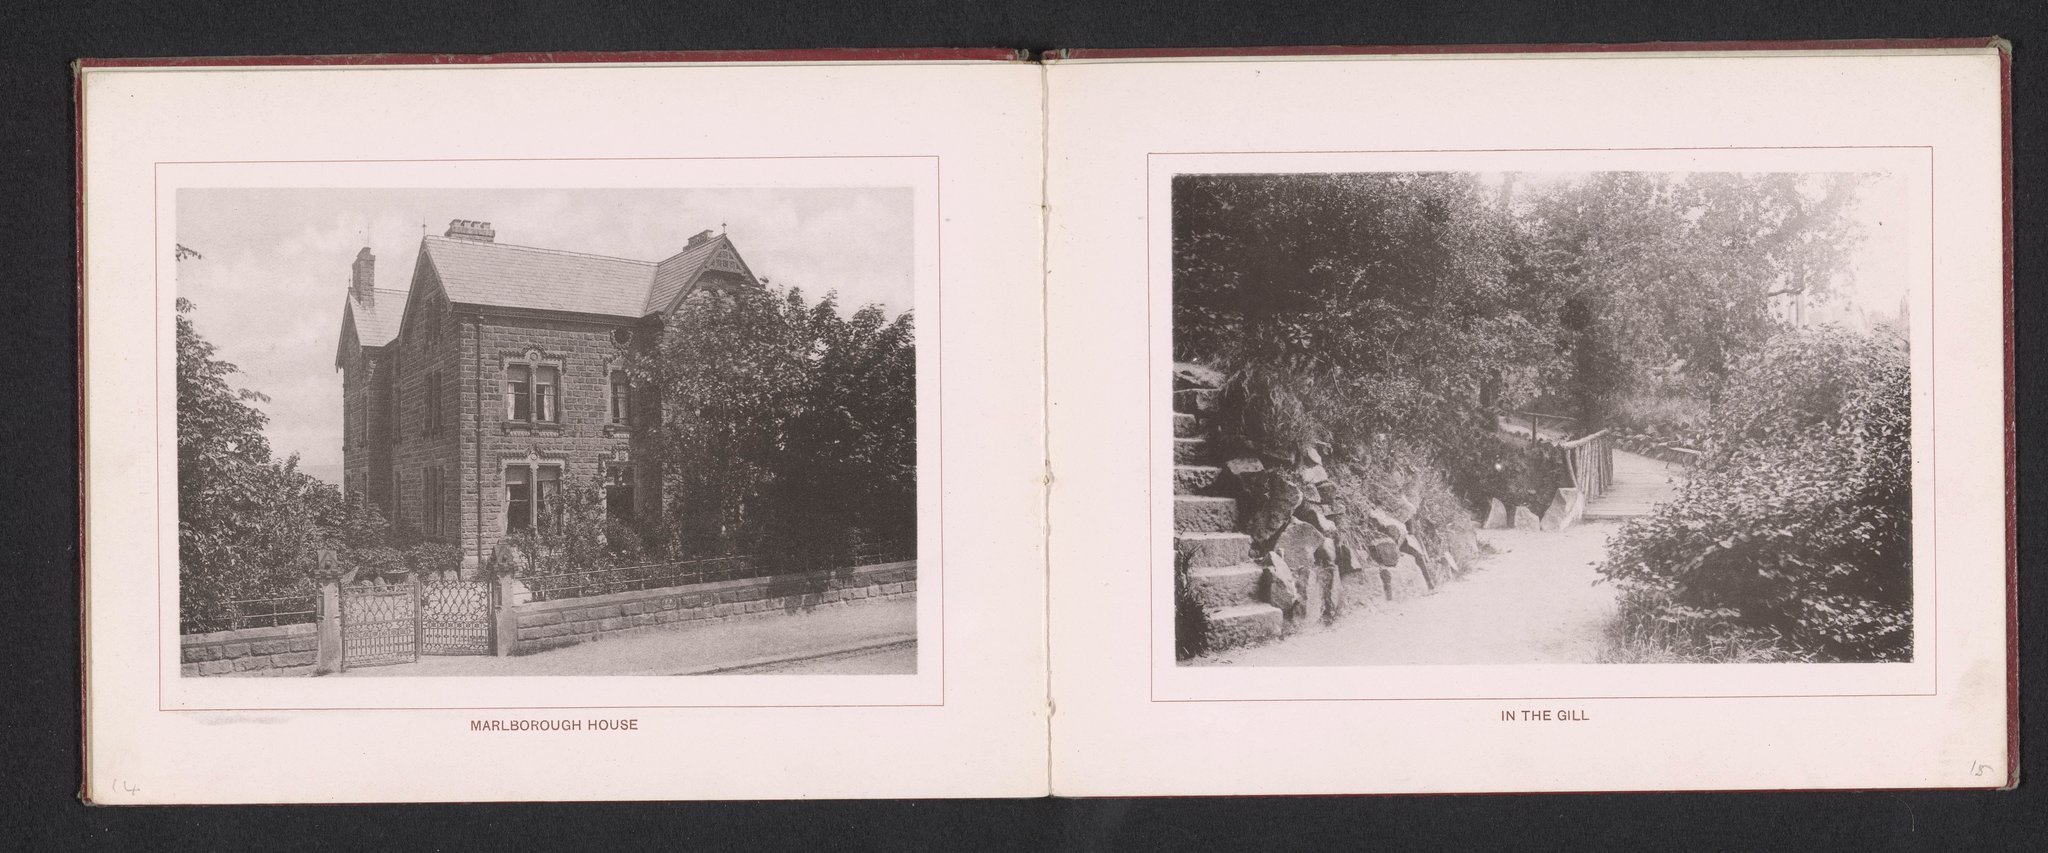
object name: photomechanical print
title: Marlborough House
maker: Anonymous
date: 1890-1900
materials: paper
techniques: photograph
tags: façade (of house or building), country-house